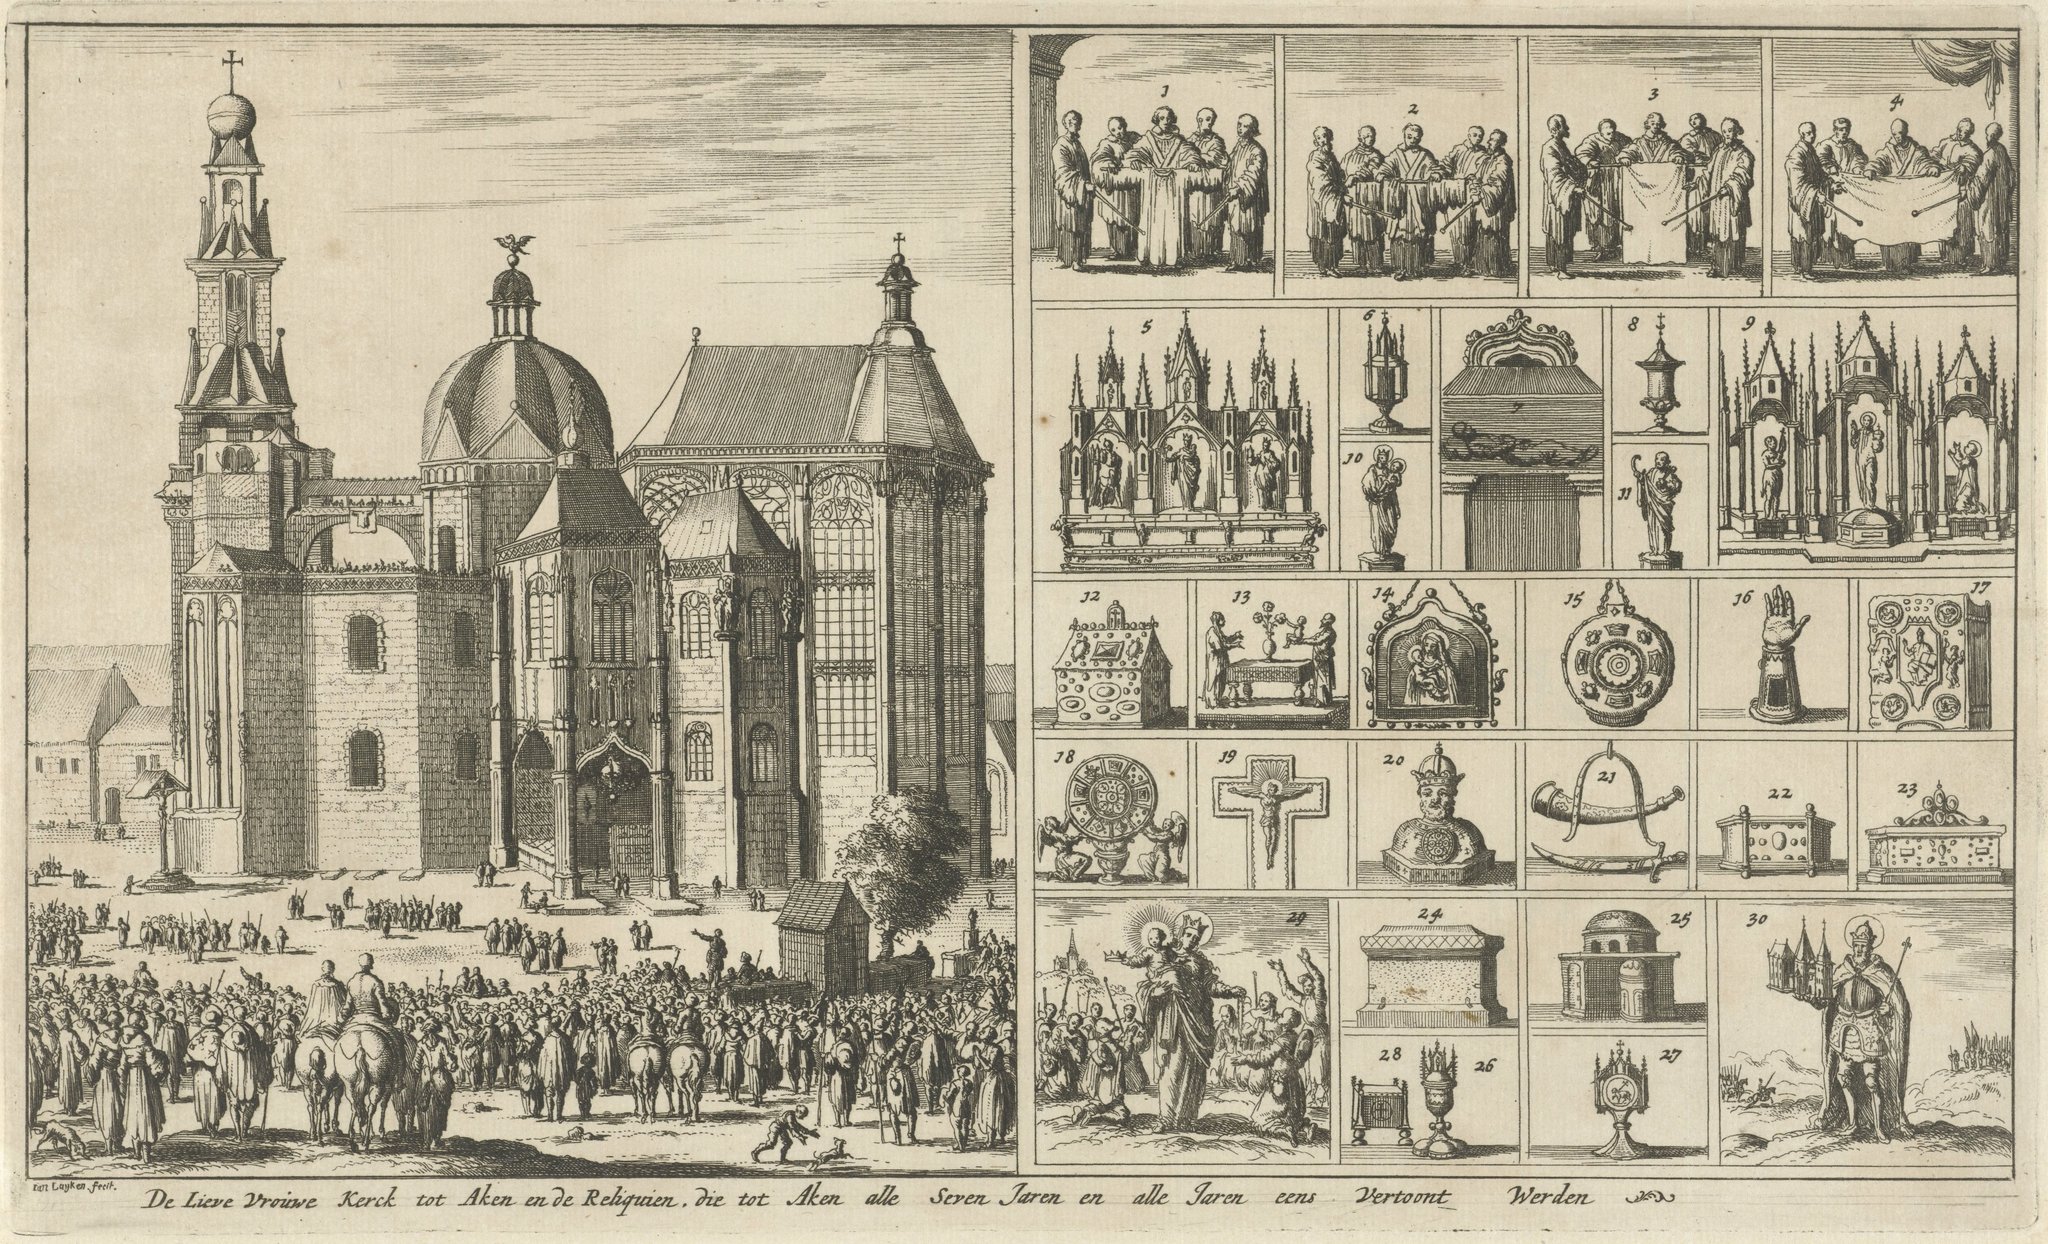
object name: print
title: De Lieve Vrouwe kerck tot Aken en de Reliquien die tot Aken alle Seven Jaren en alle Jaren eens Vertoont Werden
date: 1682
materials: paper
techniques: etching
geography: amsterdam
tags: relics (and reliquaries), church (exterior)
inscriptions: collector's mark: Lugt 2228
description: Illustratie opgenomen in: Brown, Edward. Naauwkeurige en gedenkwaardige reysen van Edward Brown (...) door Nederland, Duytsland, Hongaryen, Boek III, p. 102. Amsterdam: Jan Claesz ten Hoorn, 1682.